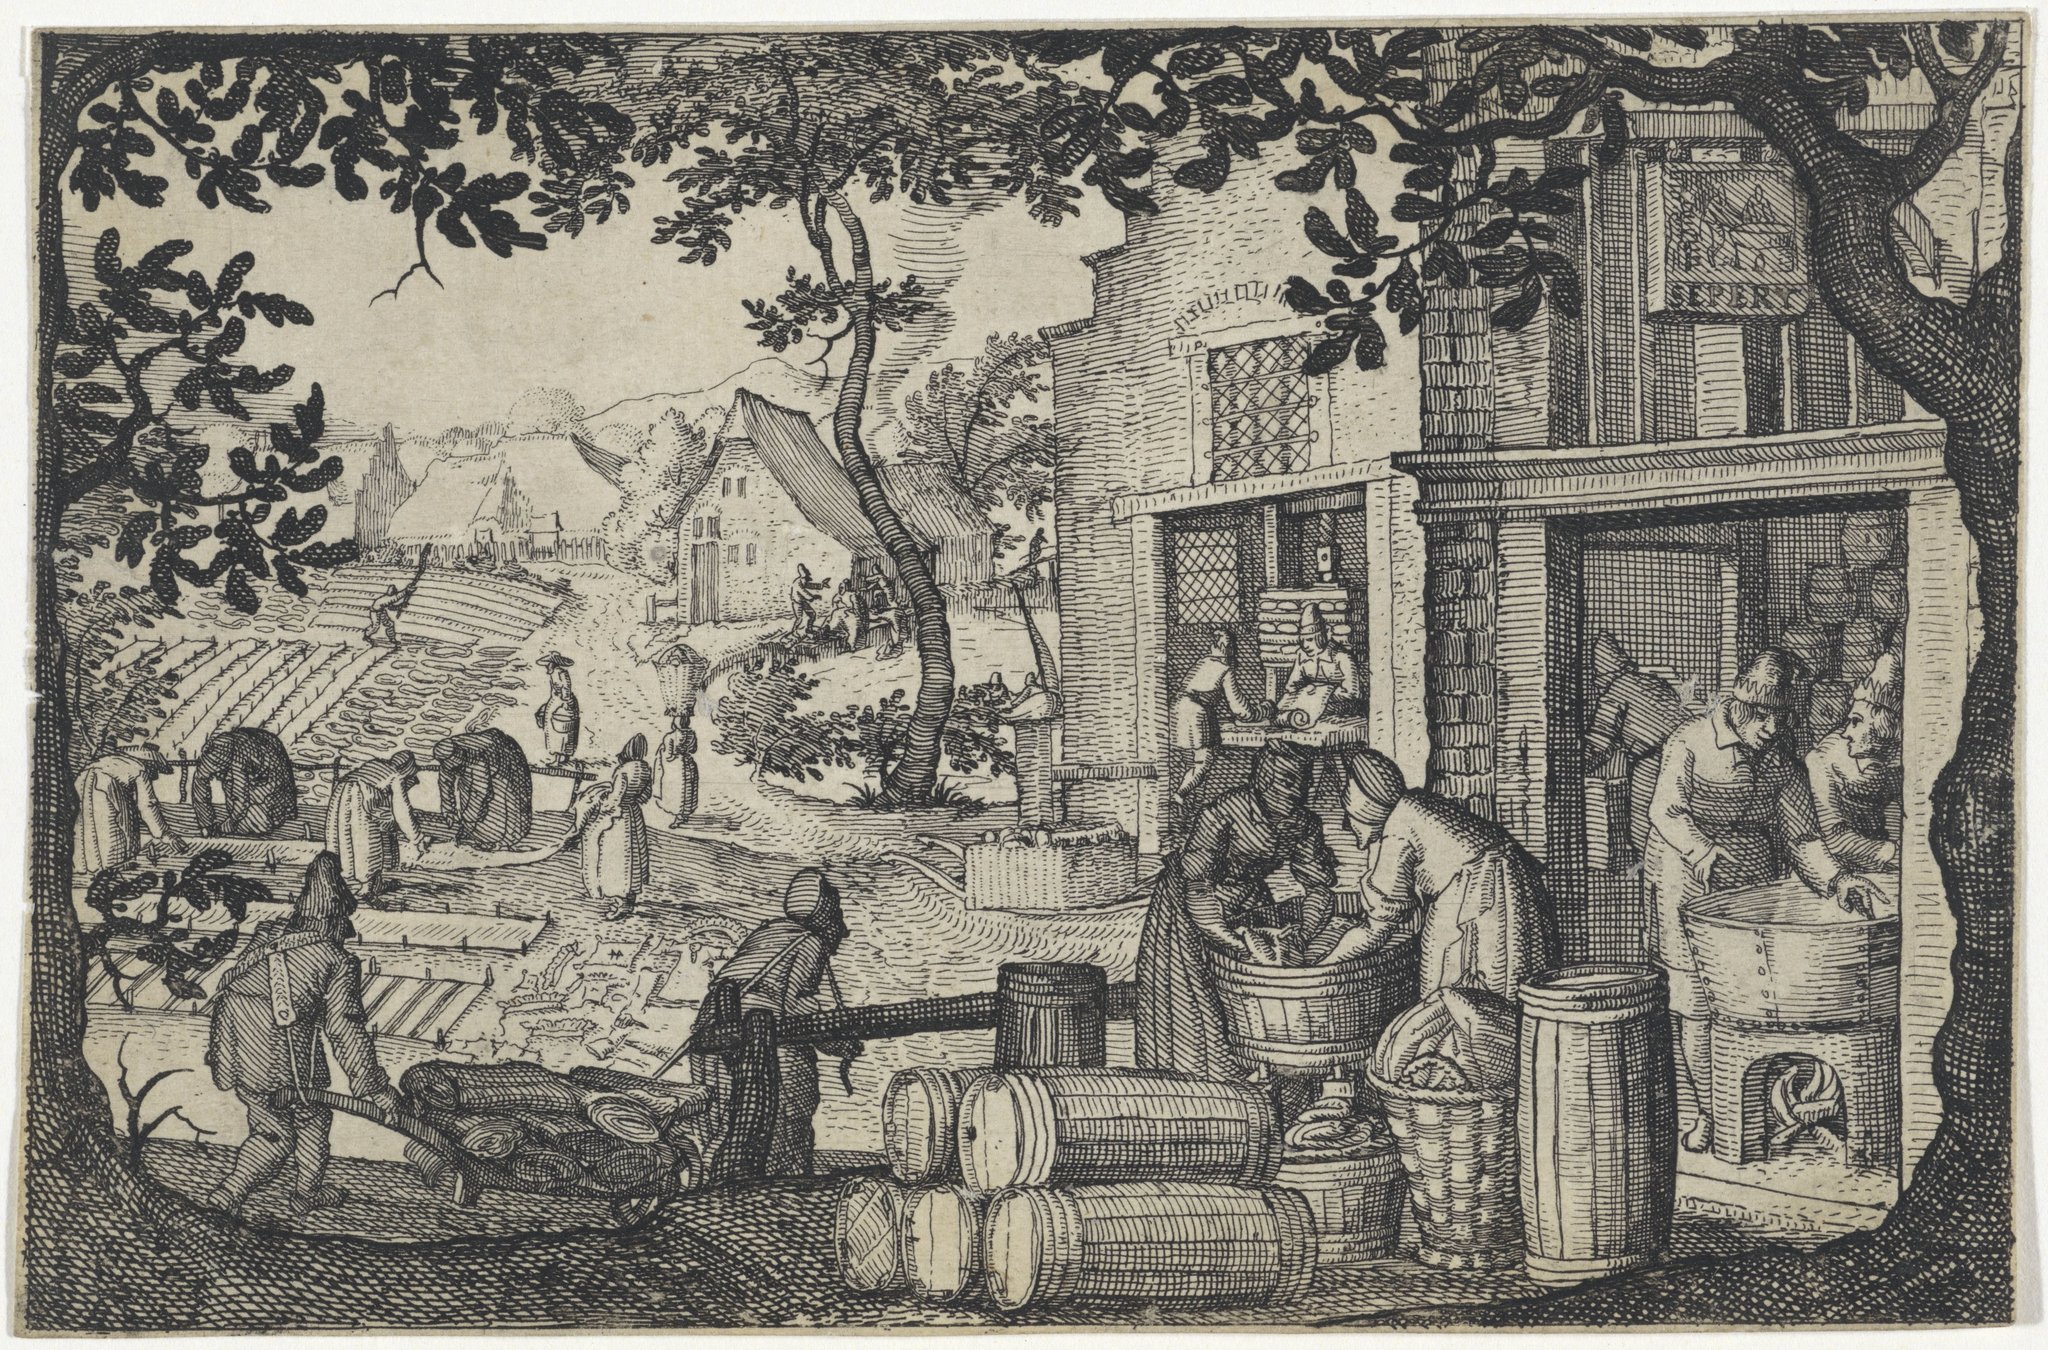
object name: print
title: Wasserij en bleekvelden, ca. 1600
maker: claes jansz. visscher (ii)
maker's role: draughtsman, print maker, publisher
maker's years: 1586-1652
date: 1608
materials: paper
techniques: etching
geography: amsterdam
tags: bleaching (laundering), laundering, signboard, wash house, home laundry, laundry room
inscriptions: collector's mark: Lugt 2228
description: Rechts een wasserij met uithangbord 'sepery', waar een grote tobbe op het vuur staat. Voor het pand twee vrouwen wassend aan een tobbe. Linksvoor wordt het wasgoed op een slede weggebracht. Op de achtergrond de blekerij.